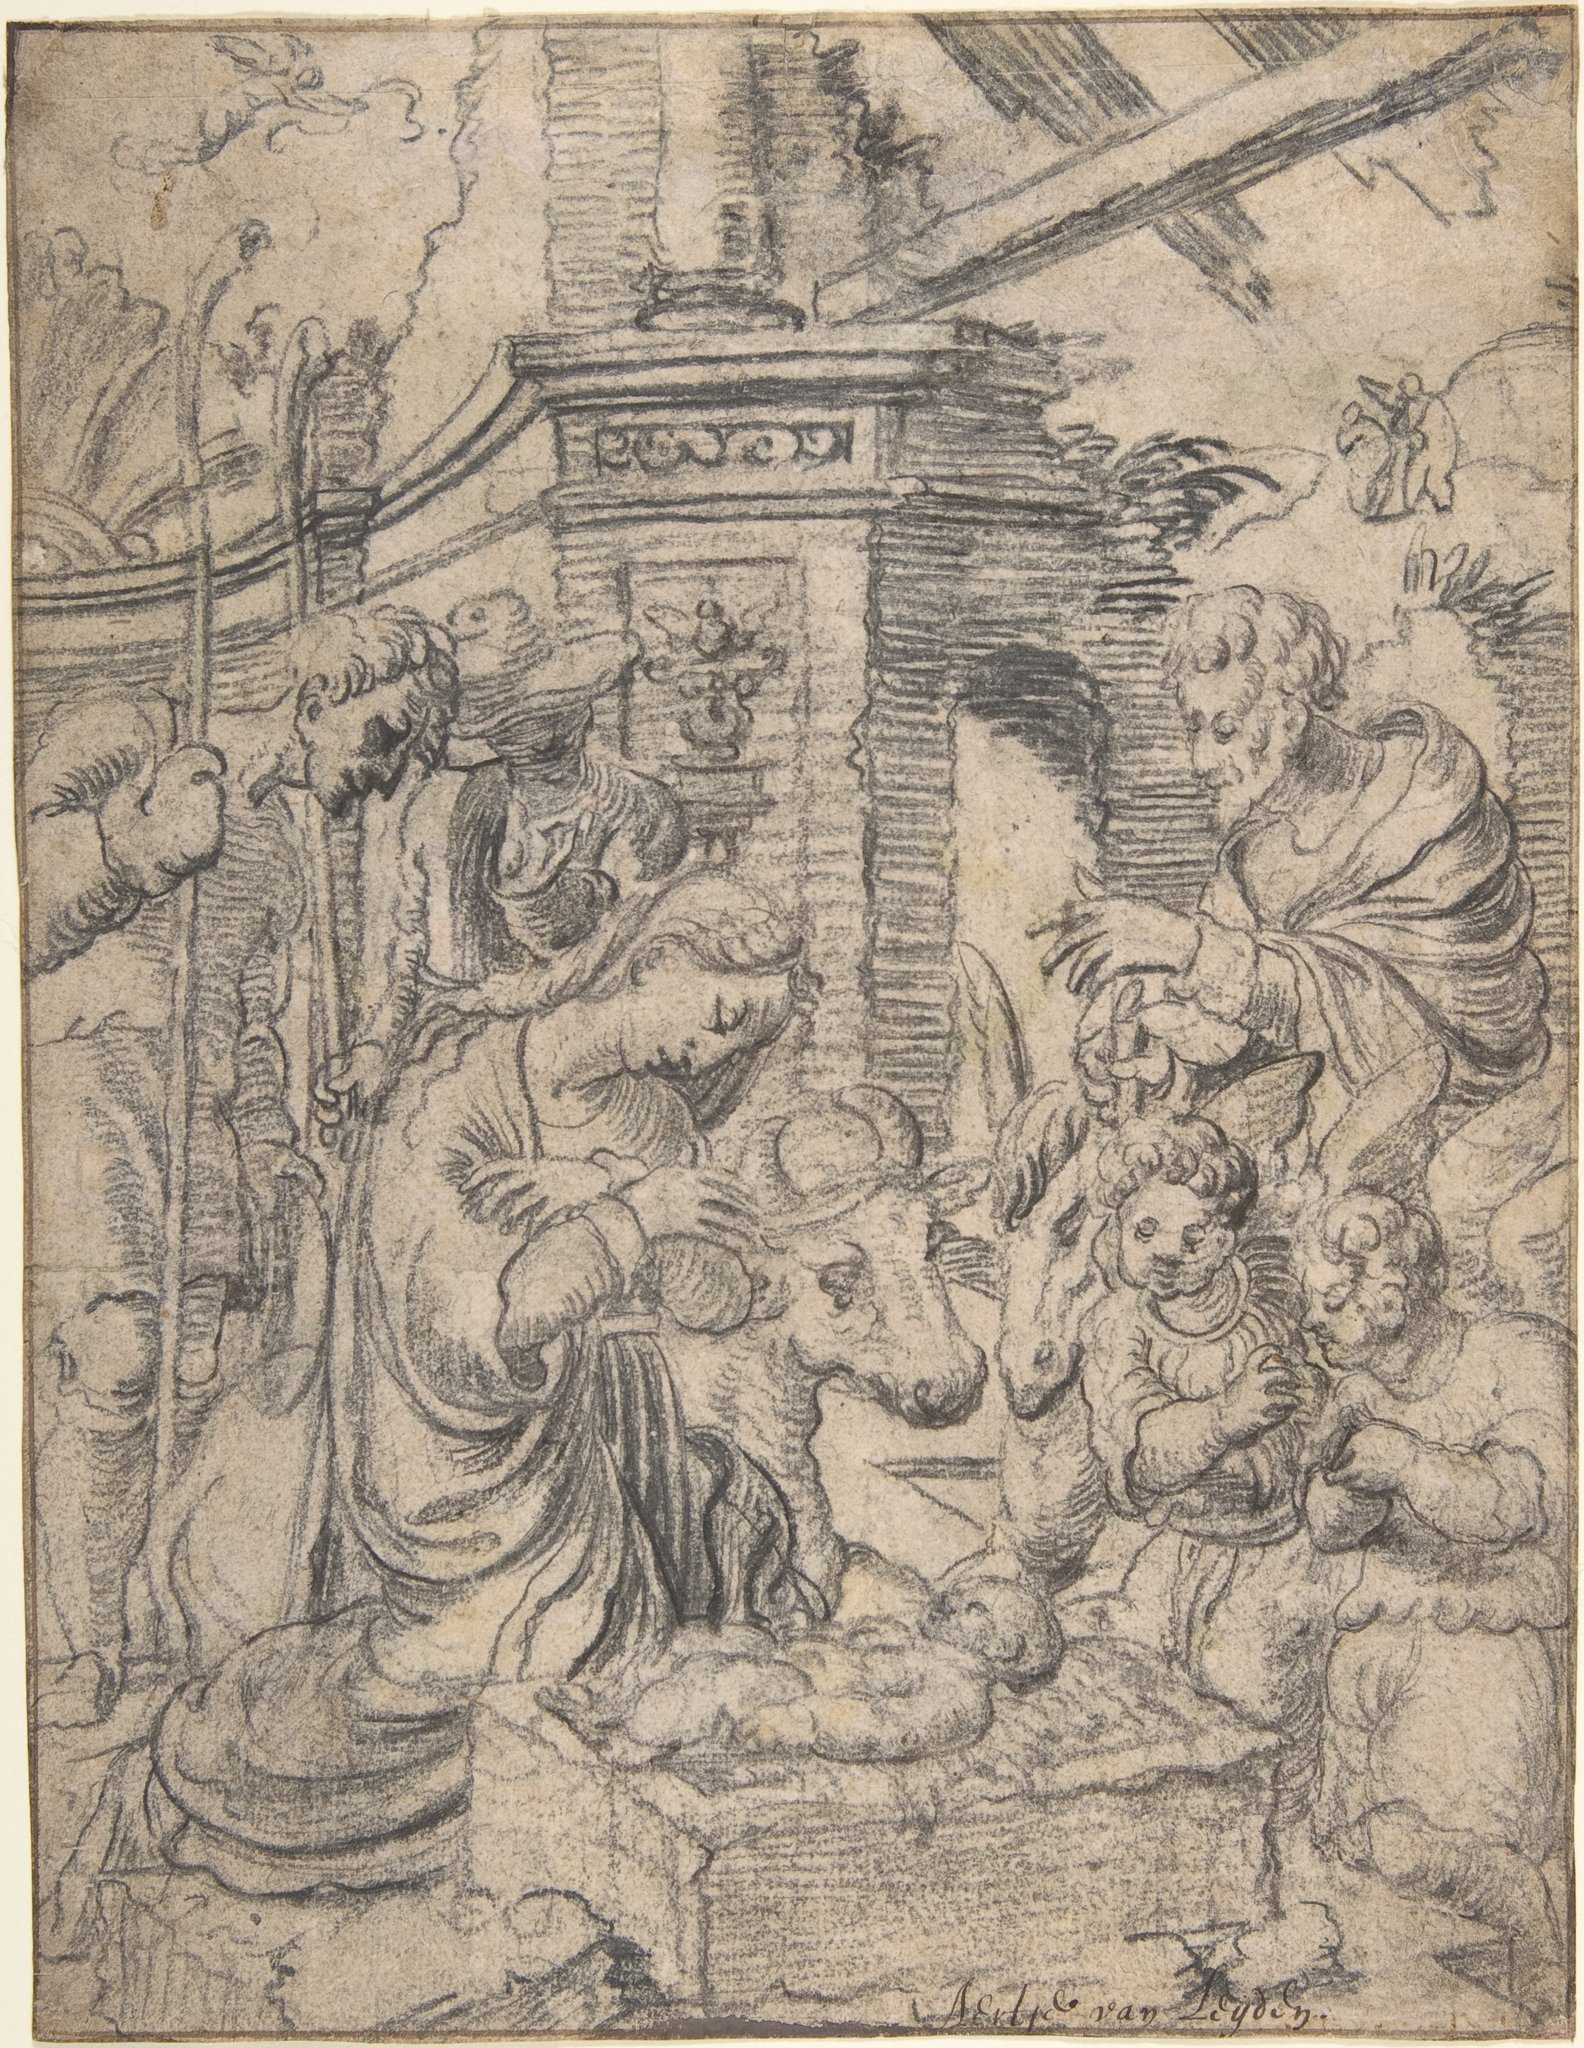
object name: drawing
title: The Adoration of the Shepherds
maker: aertgen claesz. van leyden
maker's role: artist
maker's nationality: netherlandish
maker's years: 1498-1564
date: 1501-1566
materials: chalk, paper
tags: infants,men,women,adoration of the shepherds